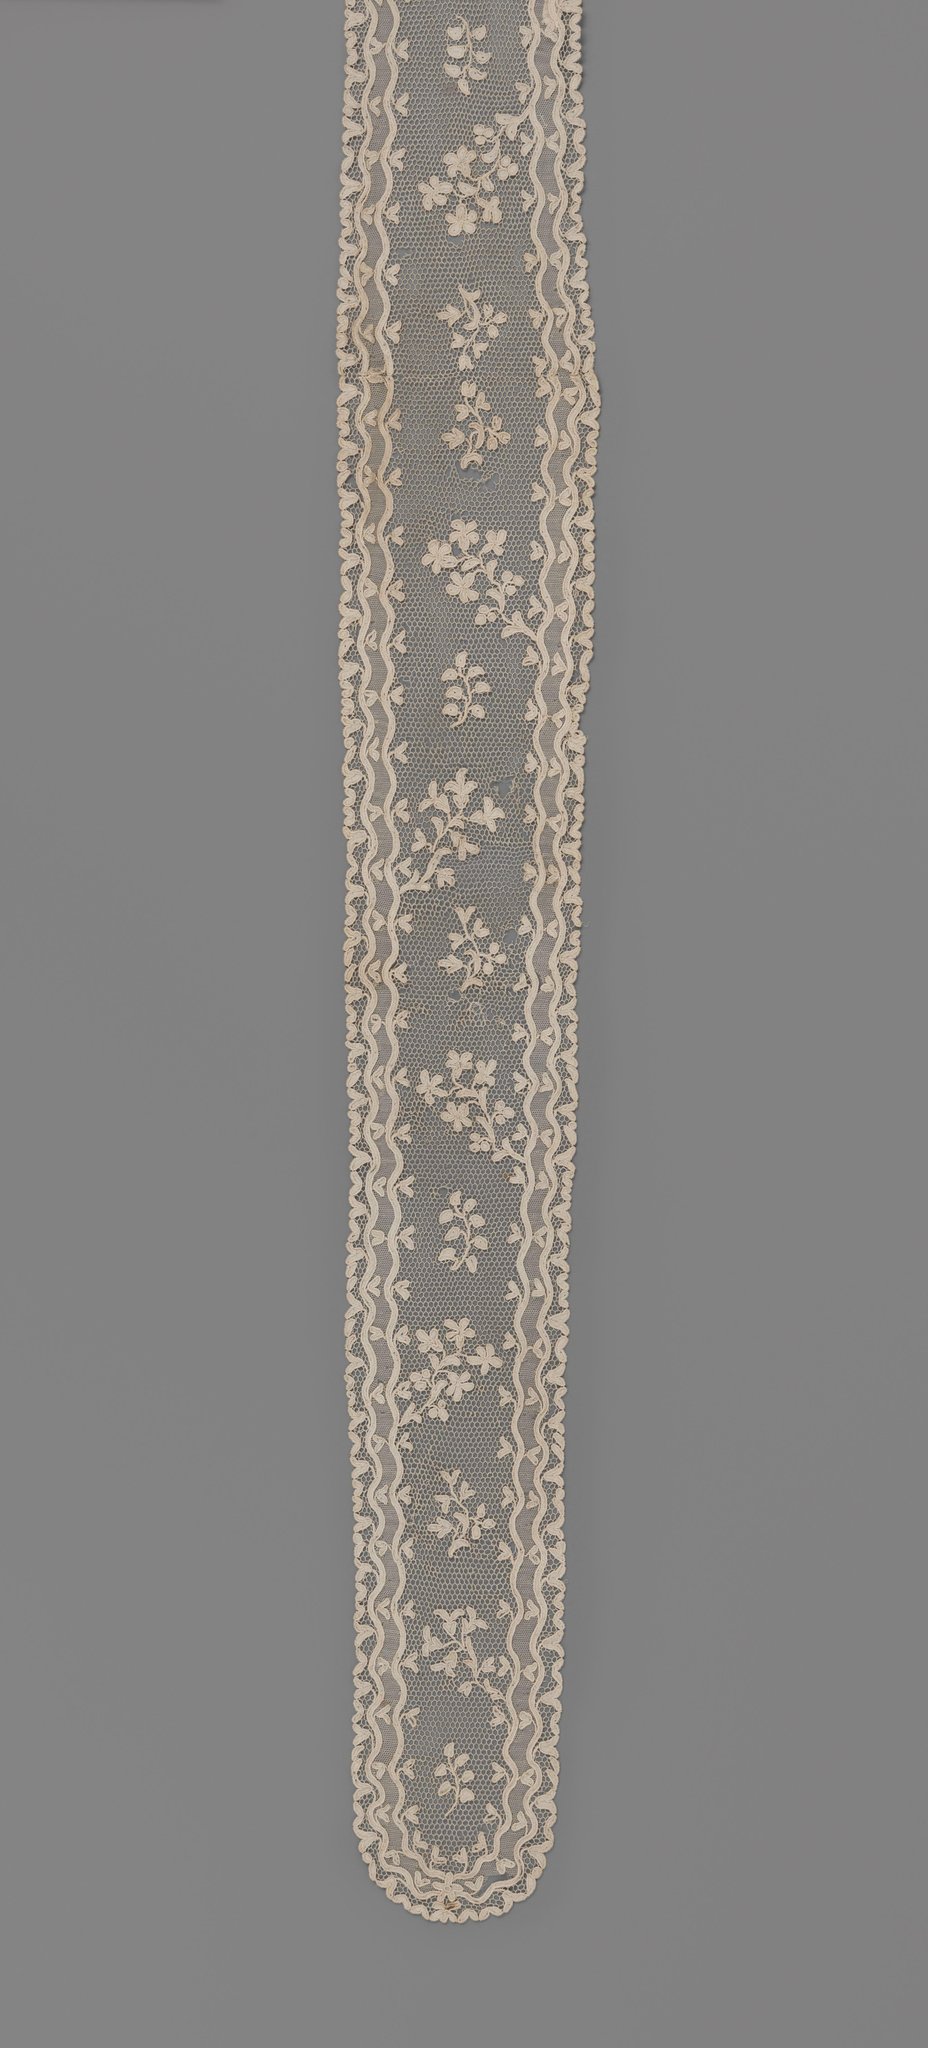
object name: womenswear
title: Twee aan elkaar genaaide mutsenslippen (barbes) van Argentankant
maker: Anonymous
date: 1775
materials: linen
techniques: lace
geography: france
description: Twee aan elkaar genaaide mutsenslippen van Argentankant. Het patroon bestaat uit bloemtakken die worden omlijst door een golvende band. De geschulpte randen bestaan uit lelies en bladeren.